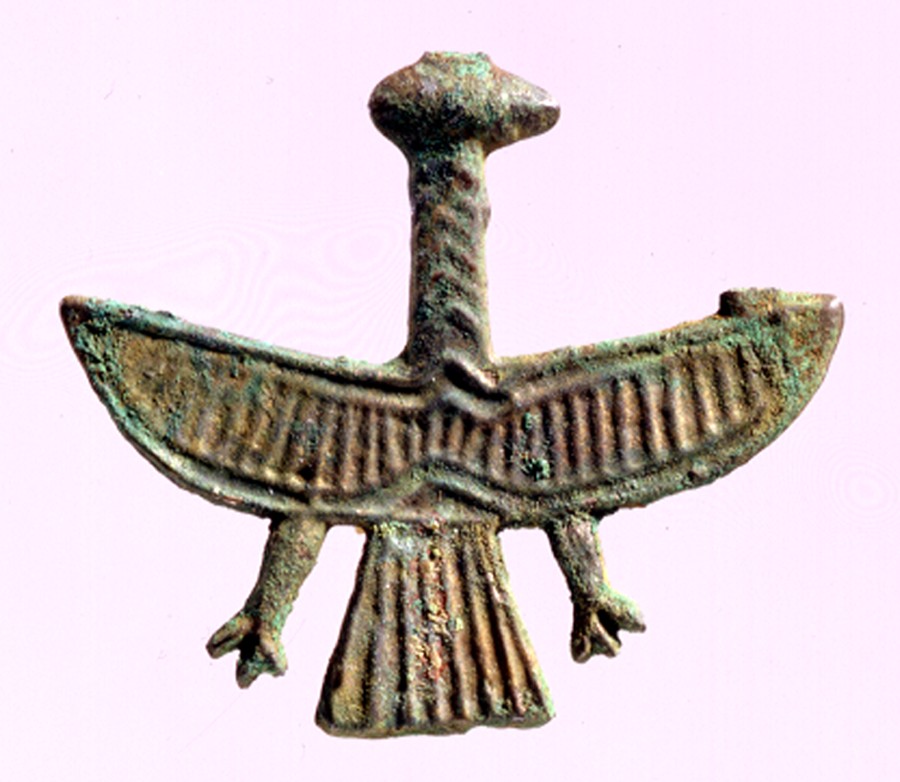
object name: plaque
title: Plaque in the Shape of a Bird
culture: chinese, northeast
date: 800-601 BCE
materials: bronze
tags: birds